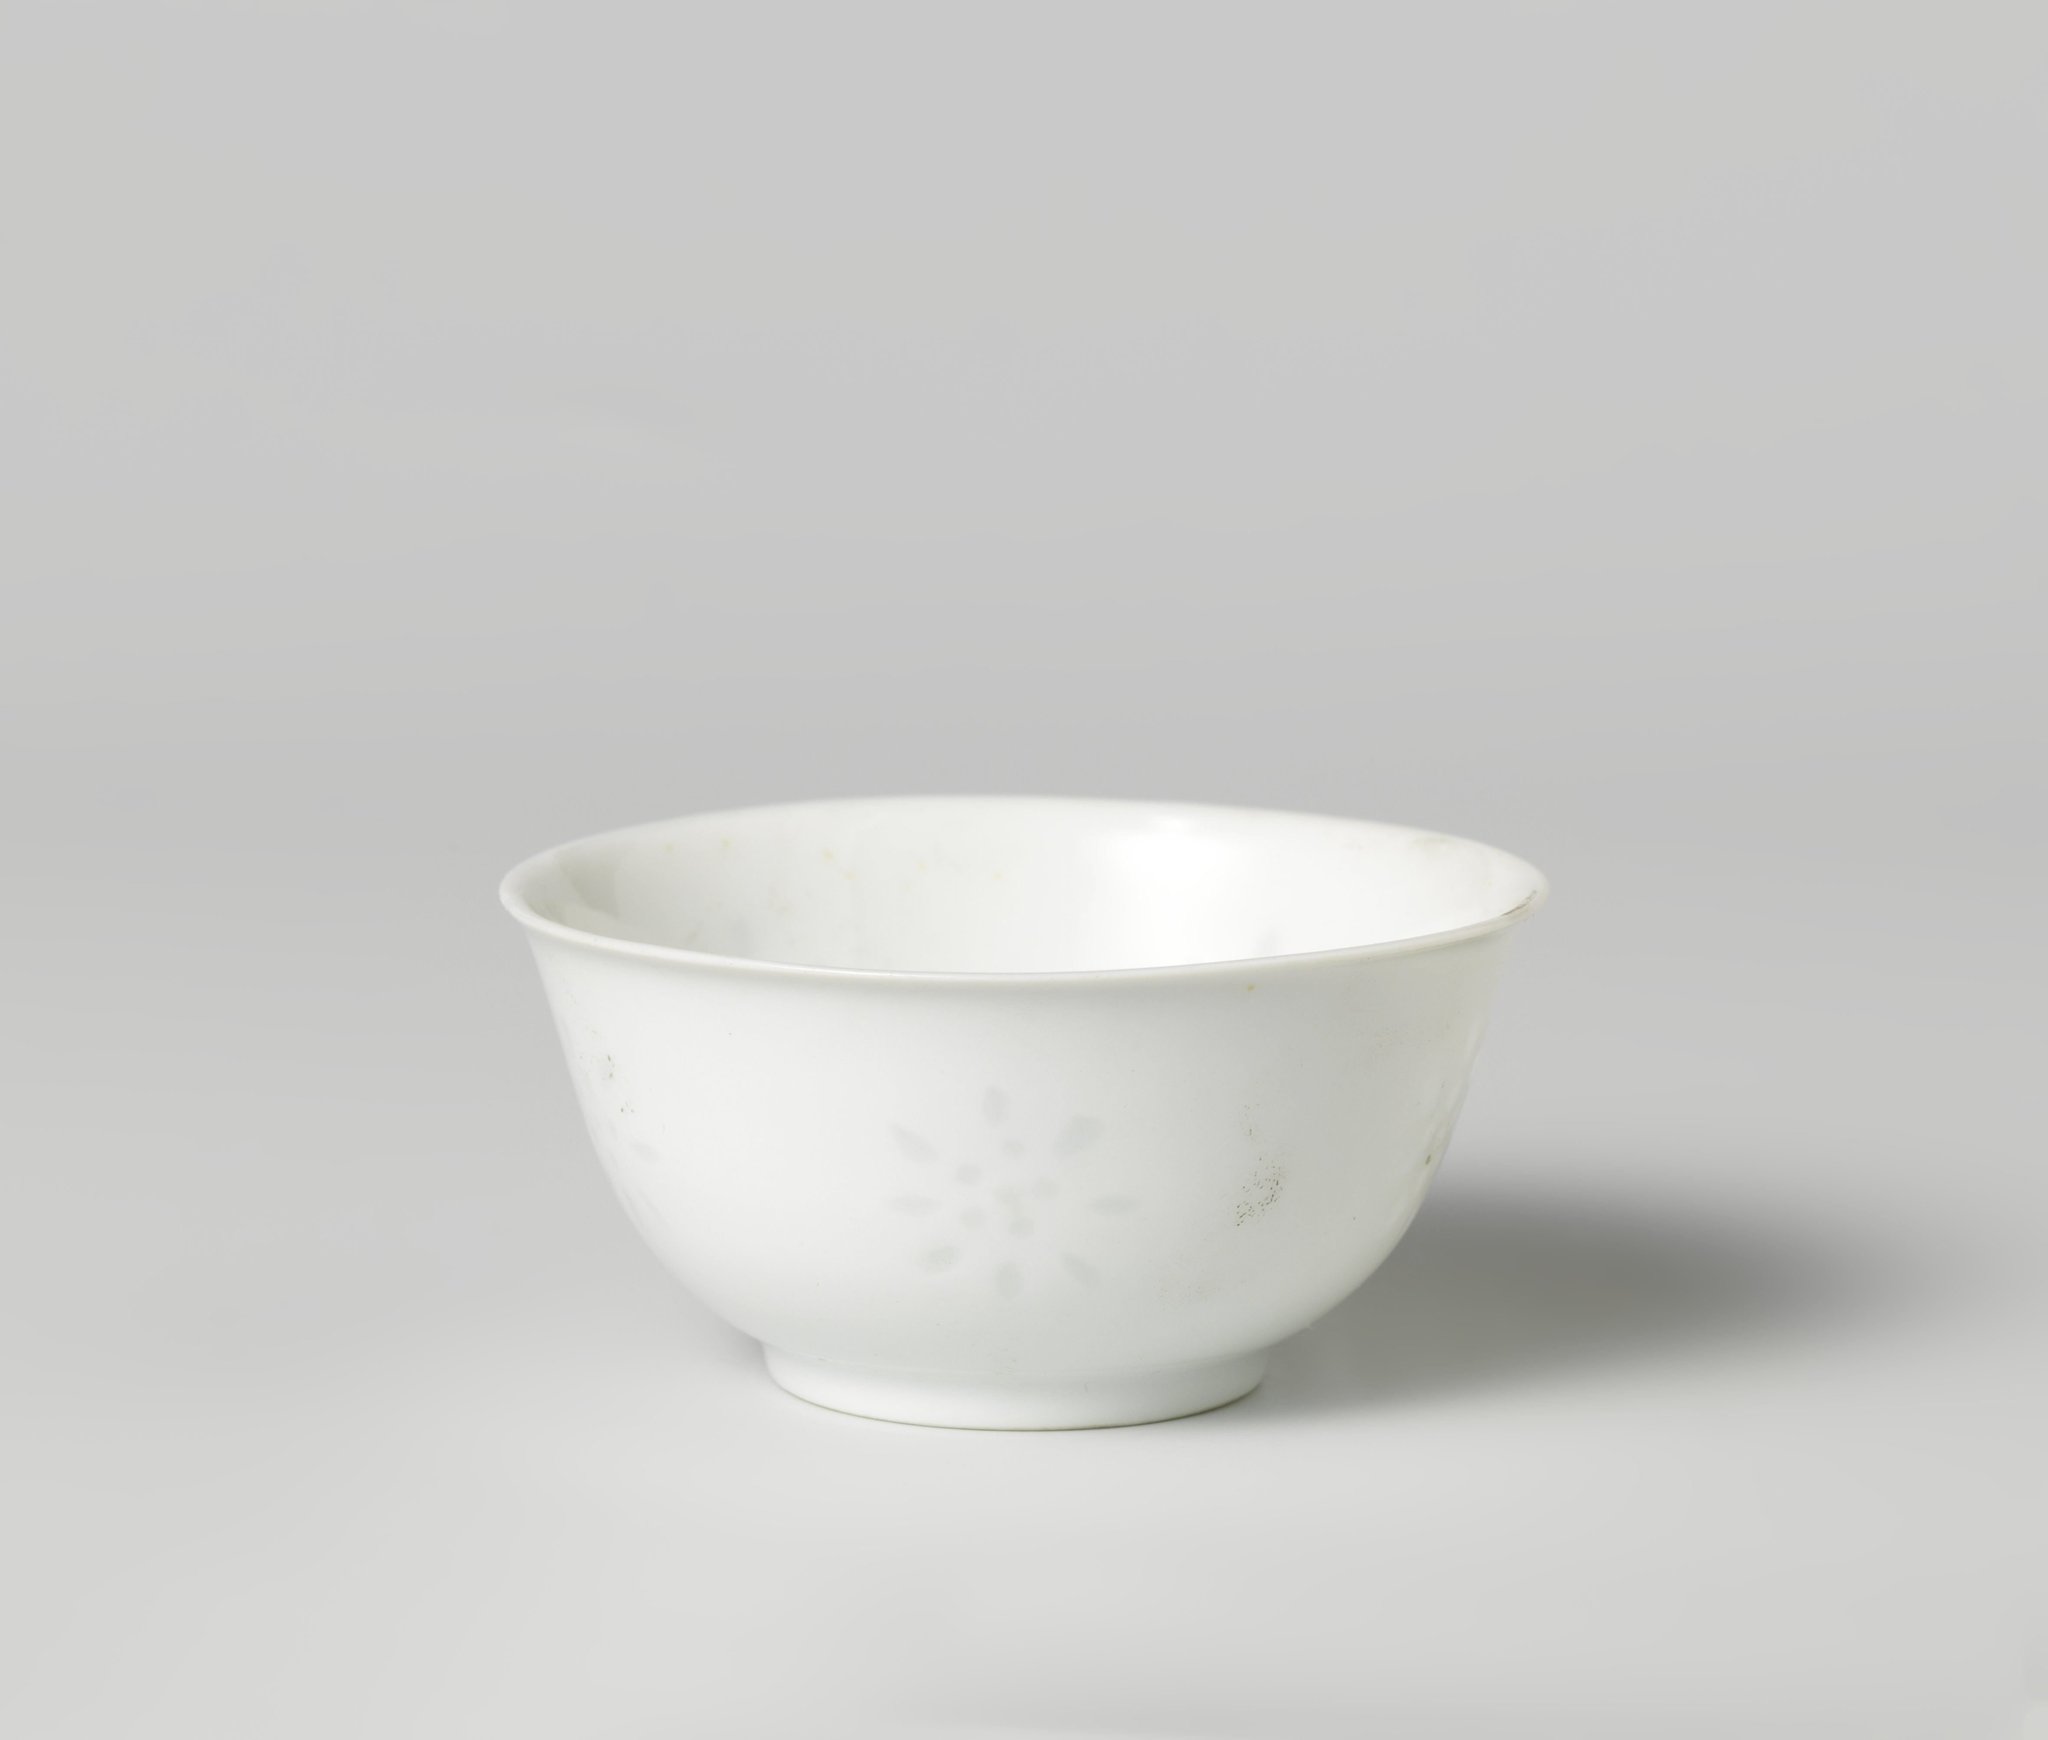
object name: kop en schotel, kop en schotel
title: Cup with translucents rice-grain roundels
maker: Anonymous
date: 1700-1724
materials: glaze, porcelain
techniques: embroidery, firing, turning, vitrification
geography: china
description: Klokvormige kop van porselein, bedekt met een doorschijnend wit glazuur. De wanden zijn opengewerkt (ajourwerk) in vijf rozetten van rijstwerk. Wit porselein, monochromen.